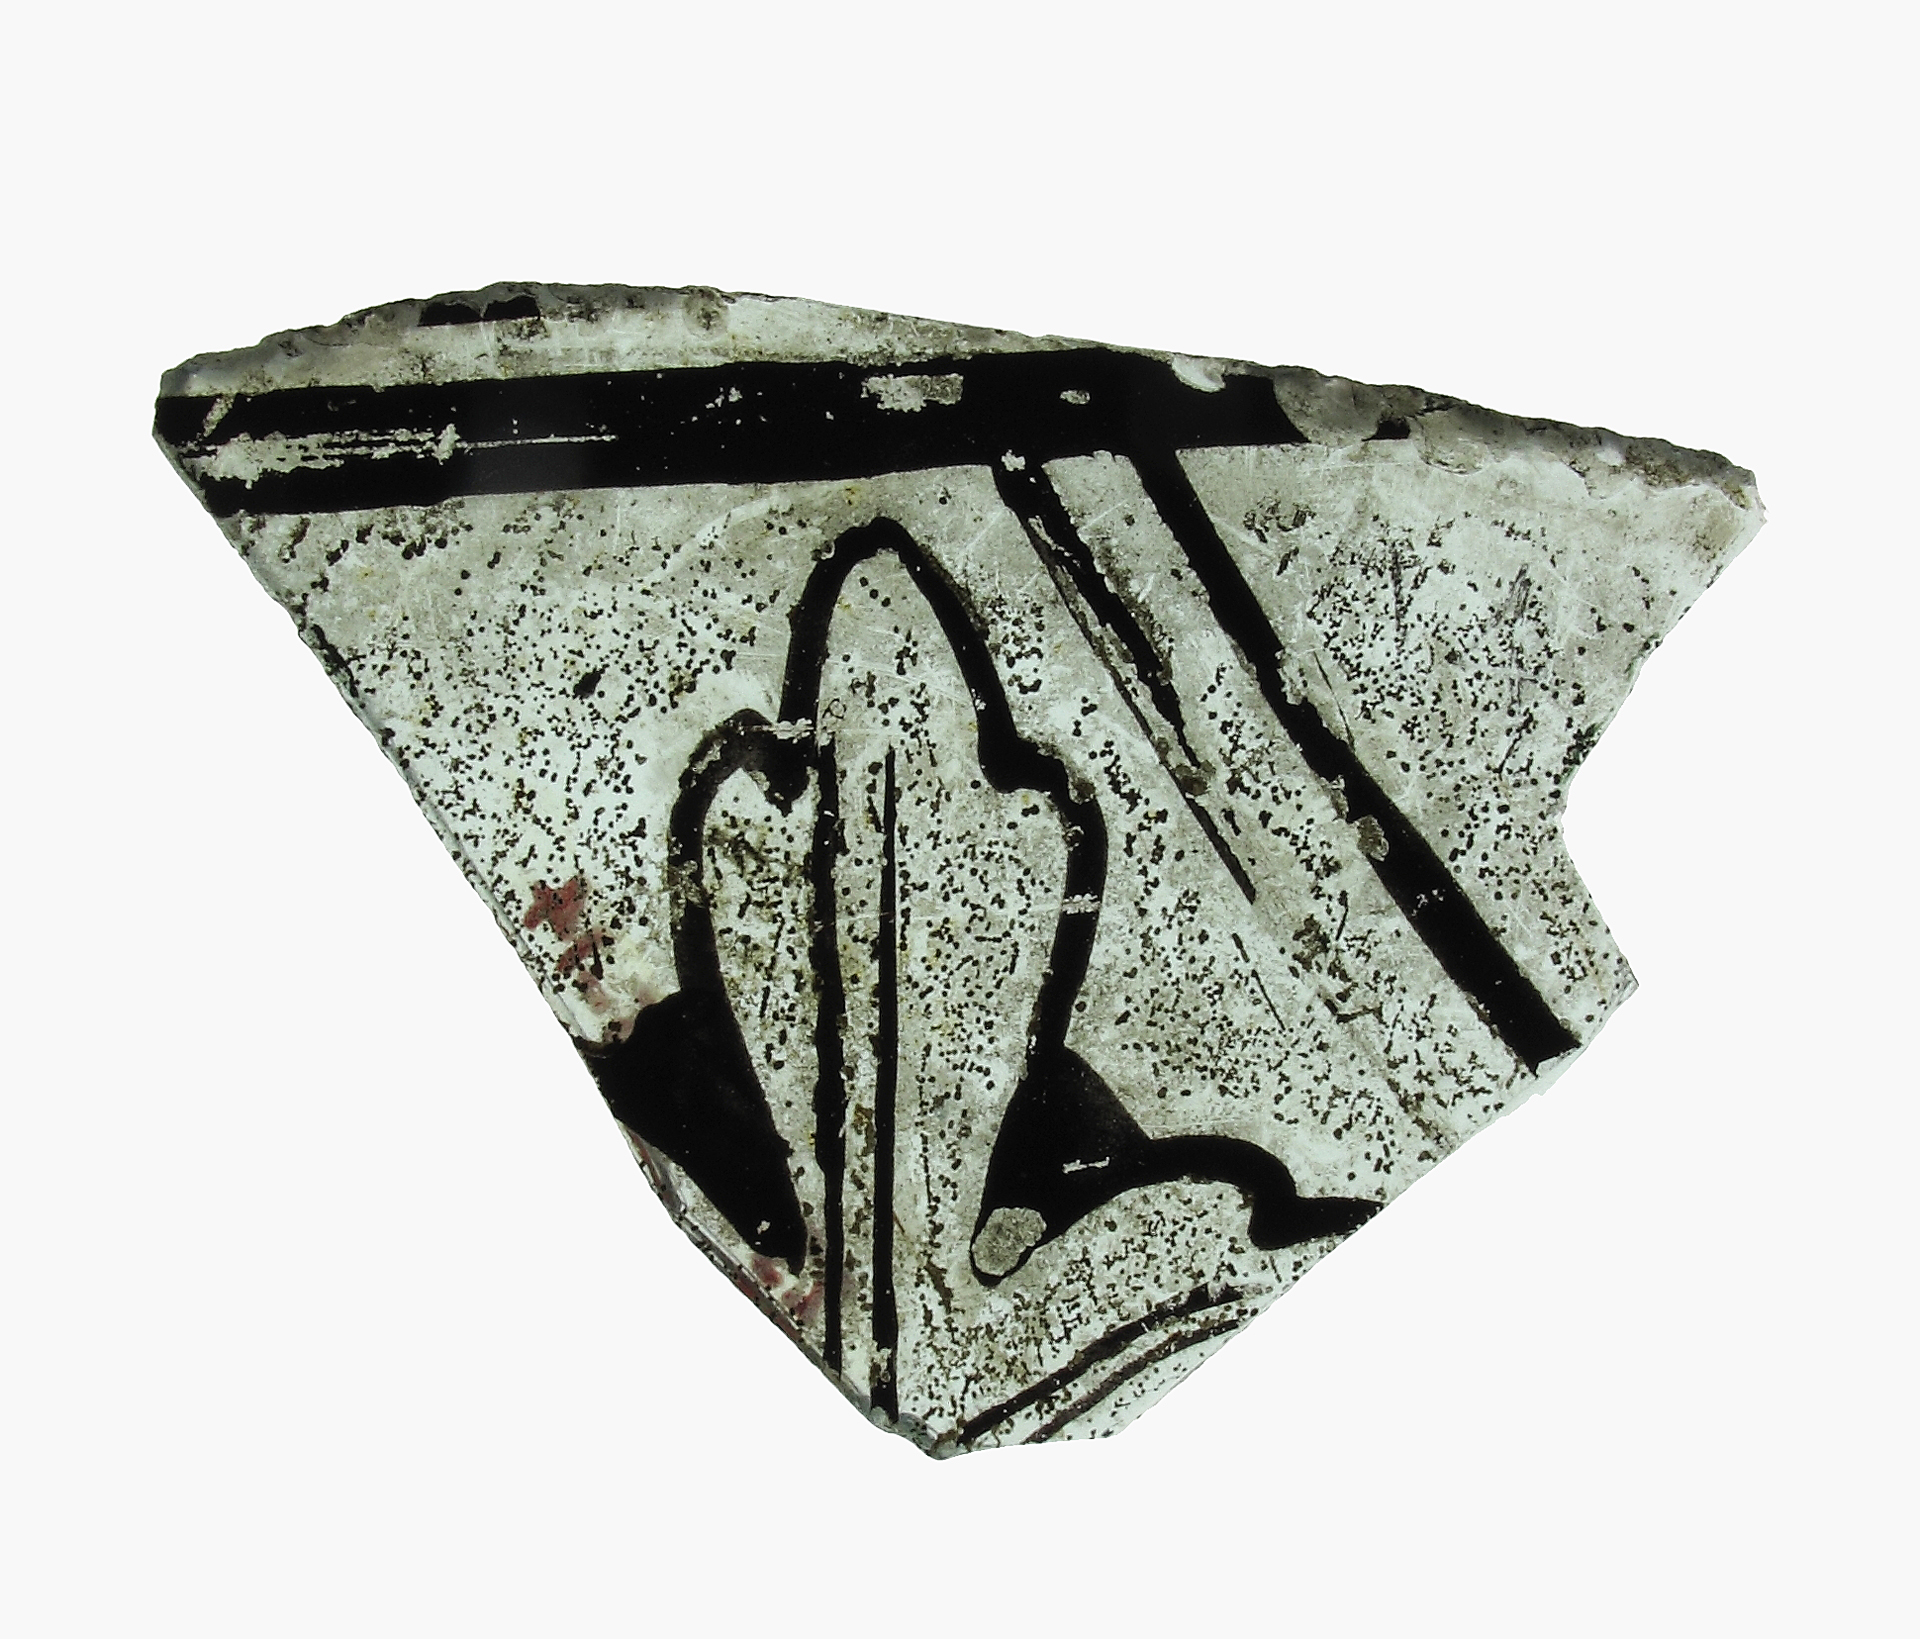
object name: fragment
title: Glass Fragment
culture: french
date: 1301-1400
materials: glass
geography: france